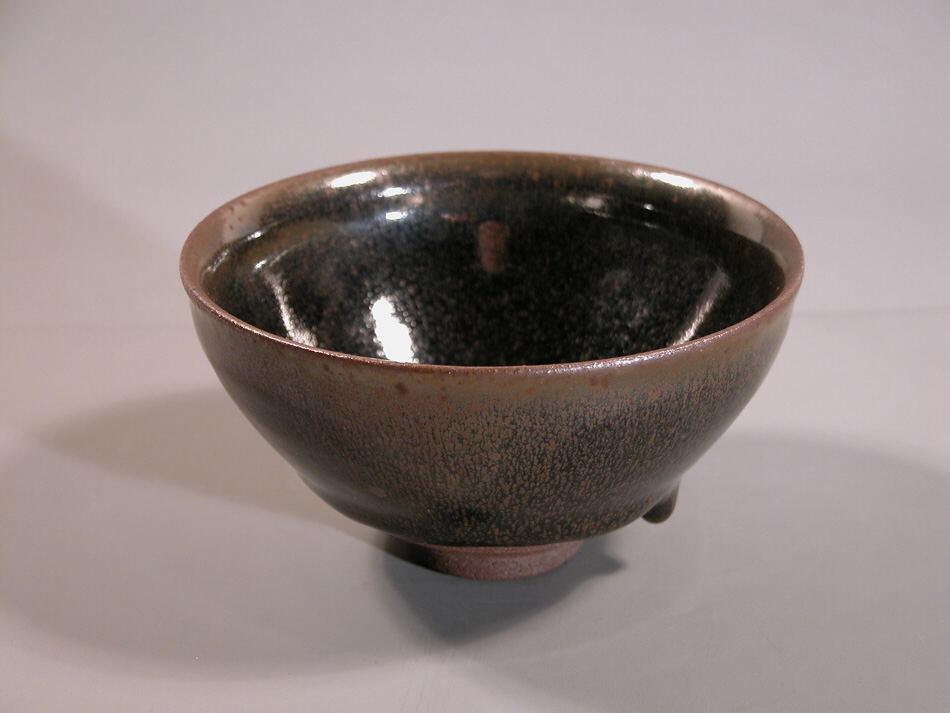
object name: ceramic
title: Bowl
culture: chinese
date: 1901-2000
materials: glaze, stoneware